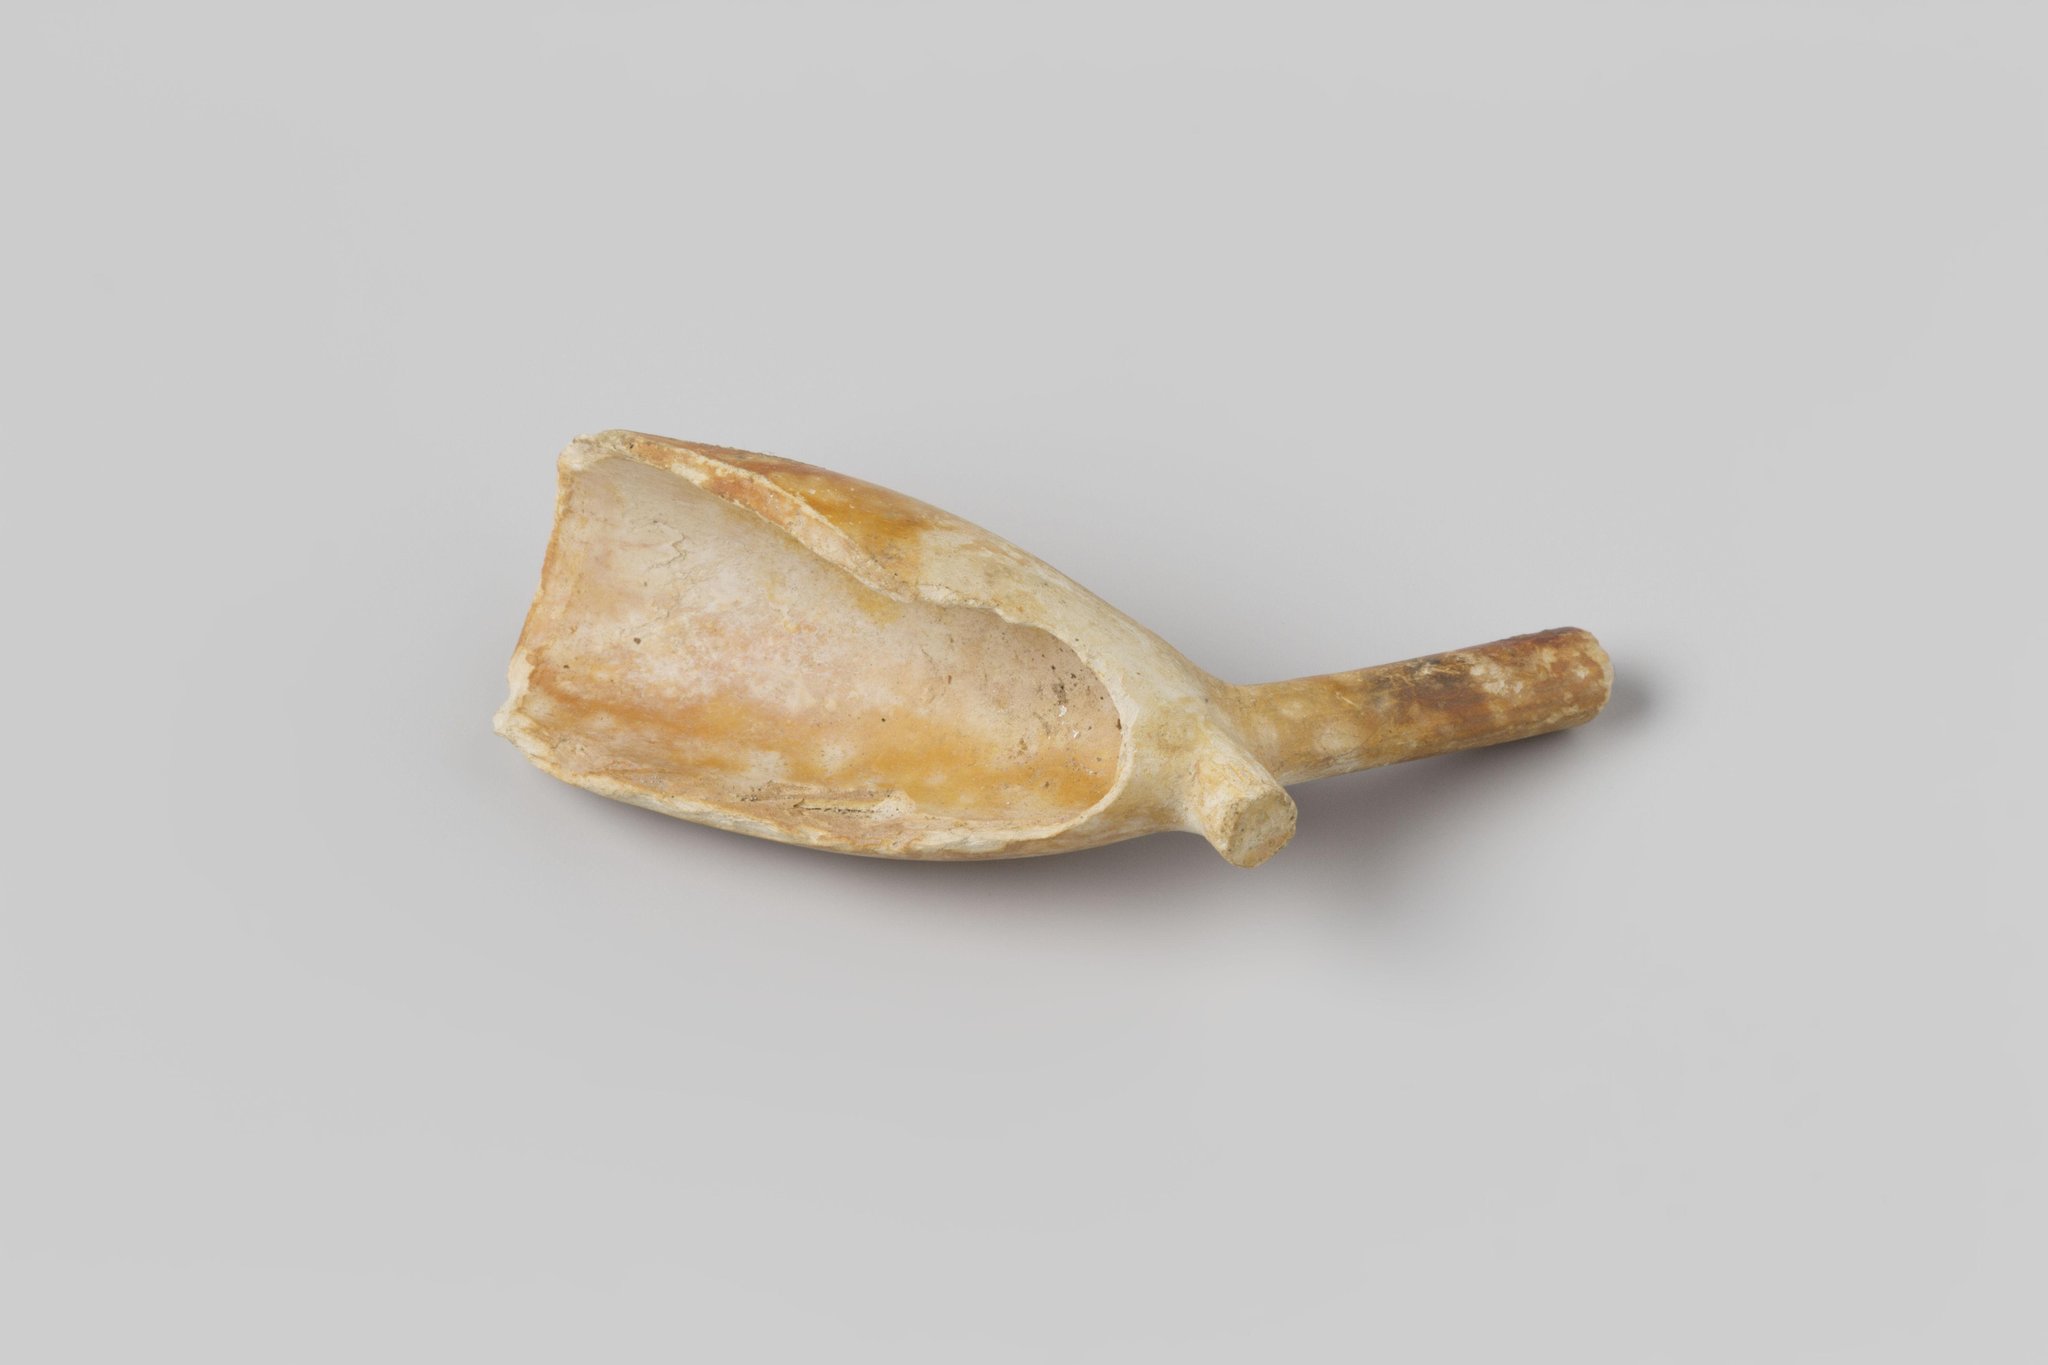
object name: pipe bowl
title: Pijpenkop met stuk steel uit het wrak van de Oost-Indiëvaarder Hollandia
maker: Anonymous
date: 1700-1743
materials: clay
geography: netherlands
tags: verenigde oostindische compagnie, hollandia (schip), annet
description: Pipe, bowl, heelmark: tobacco's brazier; fragm, 1hsm1.